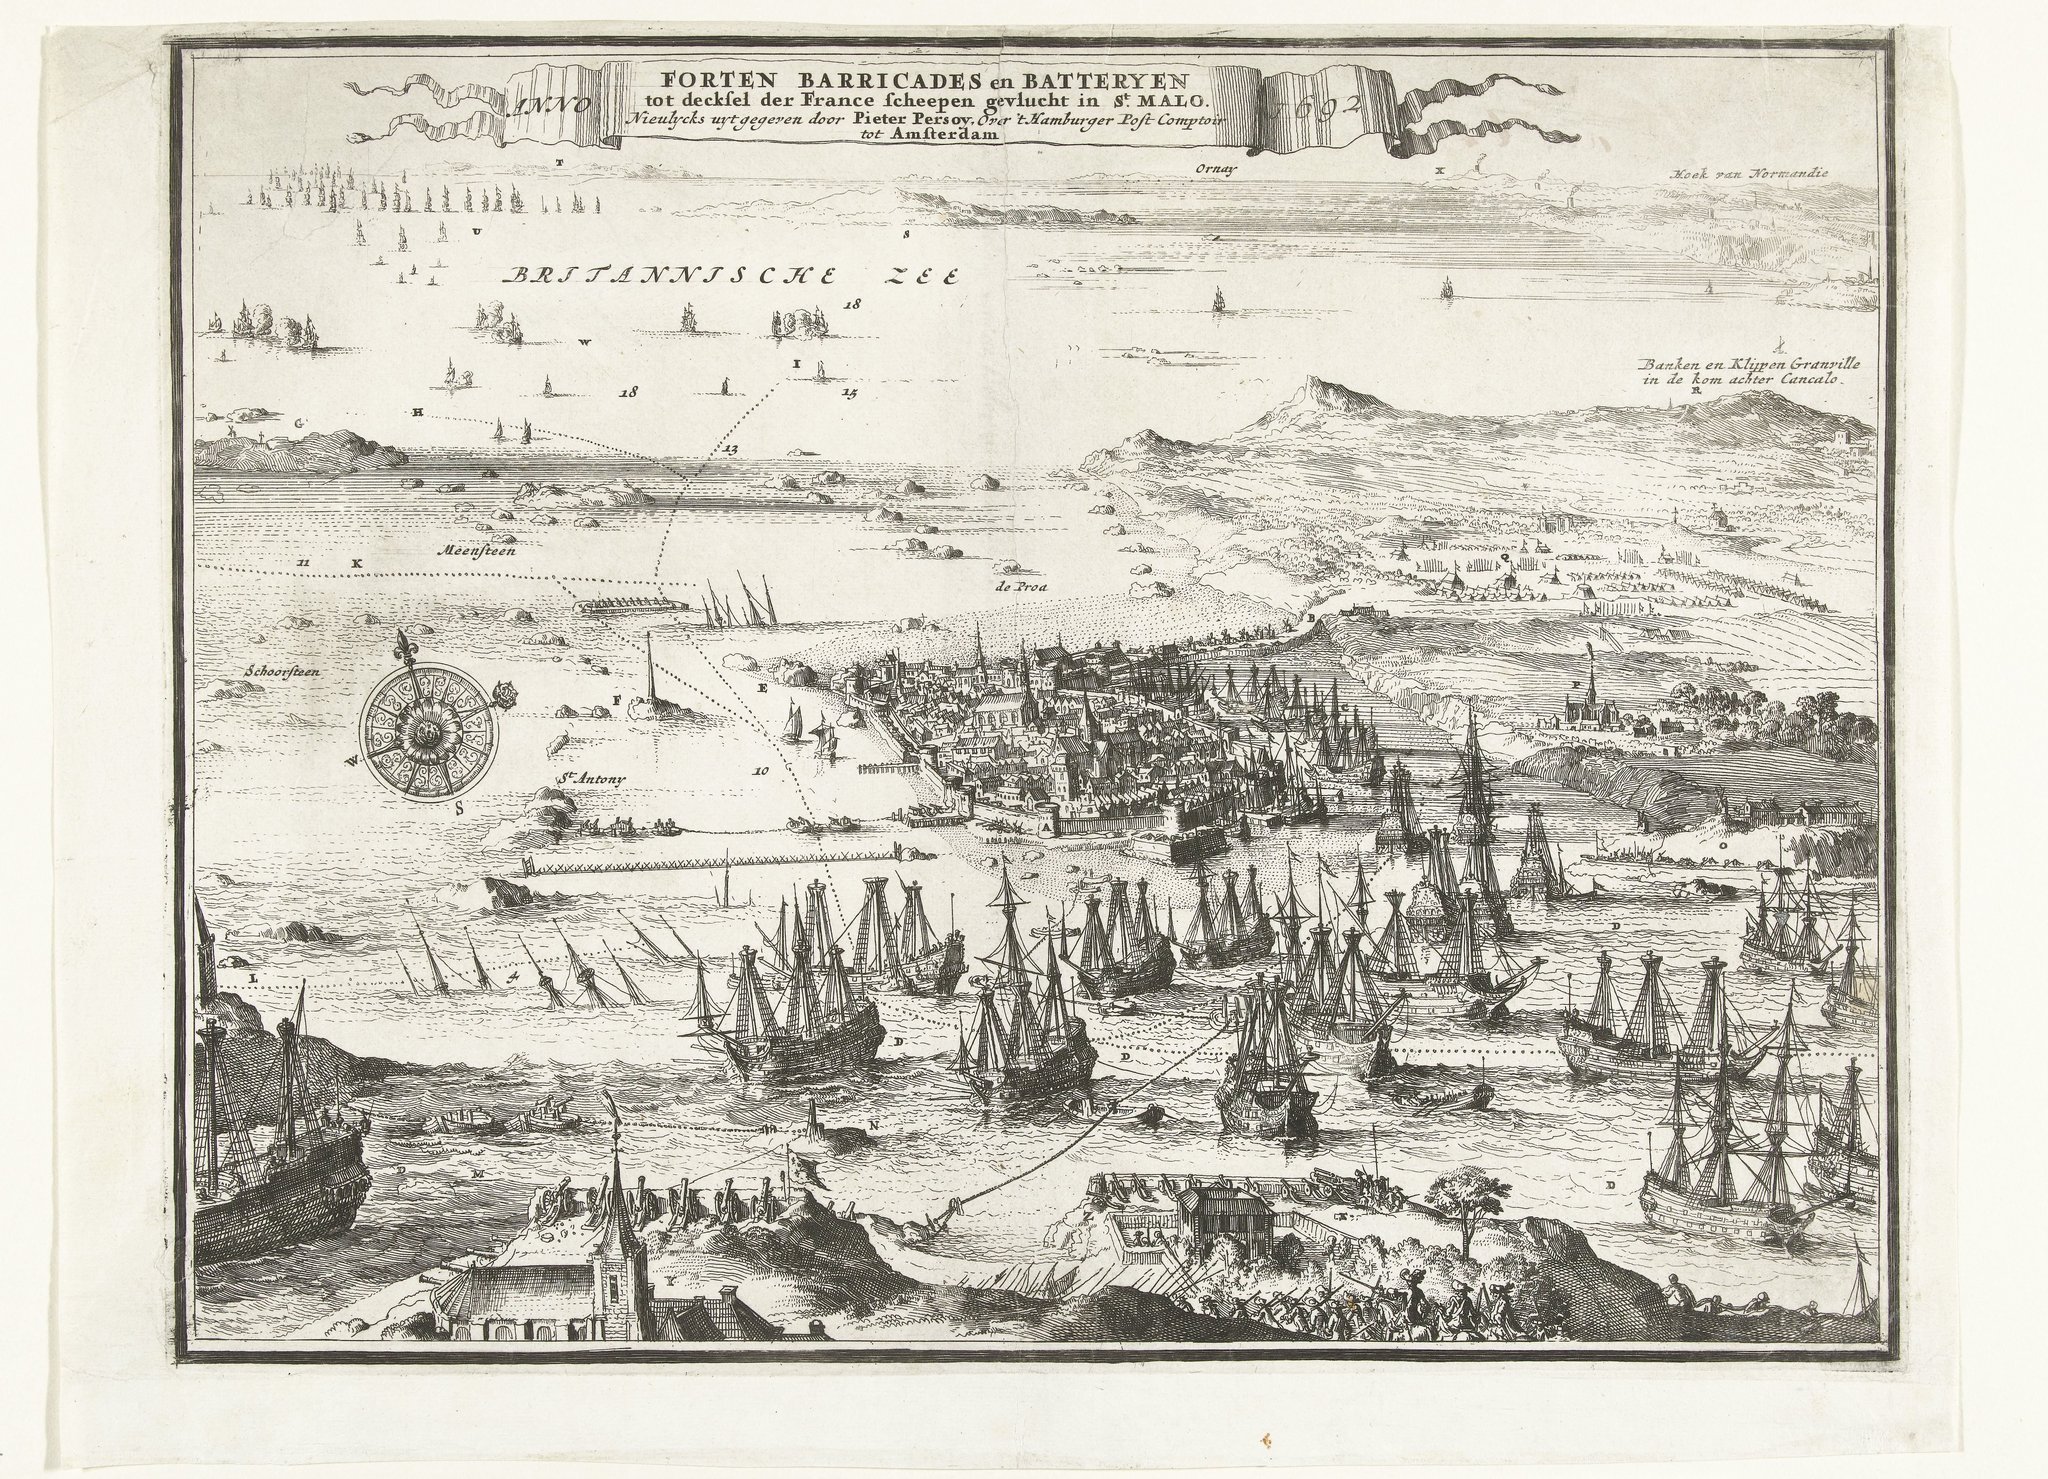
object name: print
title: Waare Afbeeldinge Der Forten, Barricades en Batteryen, tot decksel der Fransche Schepen, gevlugt in St. Malo, soo als de selve dara tegenwoordig leggen (...)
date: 1692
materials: paper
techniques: etching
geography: france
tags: harbour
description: De haven bij Saint-Malo waarheen de overgebleven Franse schepen gevlucht zijn na de nederlaag tegen de gecombineerde Engelse en Hollandse vloten in de slag bij St Kaap la Hogue in het Kanaal, 29 mei t/m 3 juni 1692. De haven afgesloten met een grote ketting. Bij de prent hoort een tekstblad.